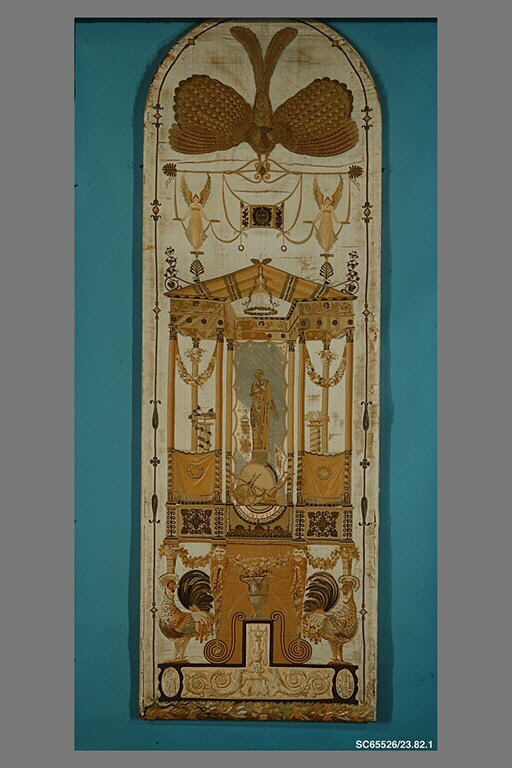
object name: wall panel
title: Pair of wall panels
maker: jean démosthène dugourc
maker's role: designer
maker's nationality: french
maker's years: 1749-1825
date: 1800-1810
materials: metal thread, silk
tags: buildings,peacocks,roosters